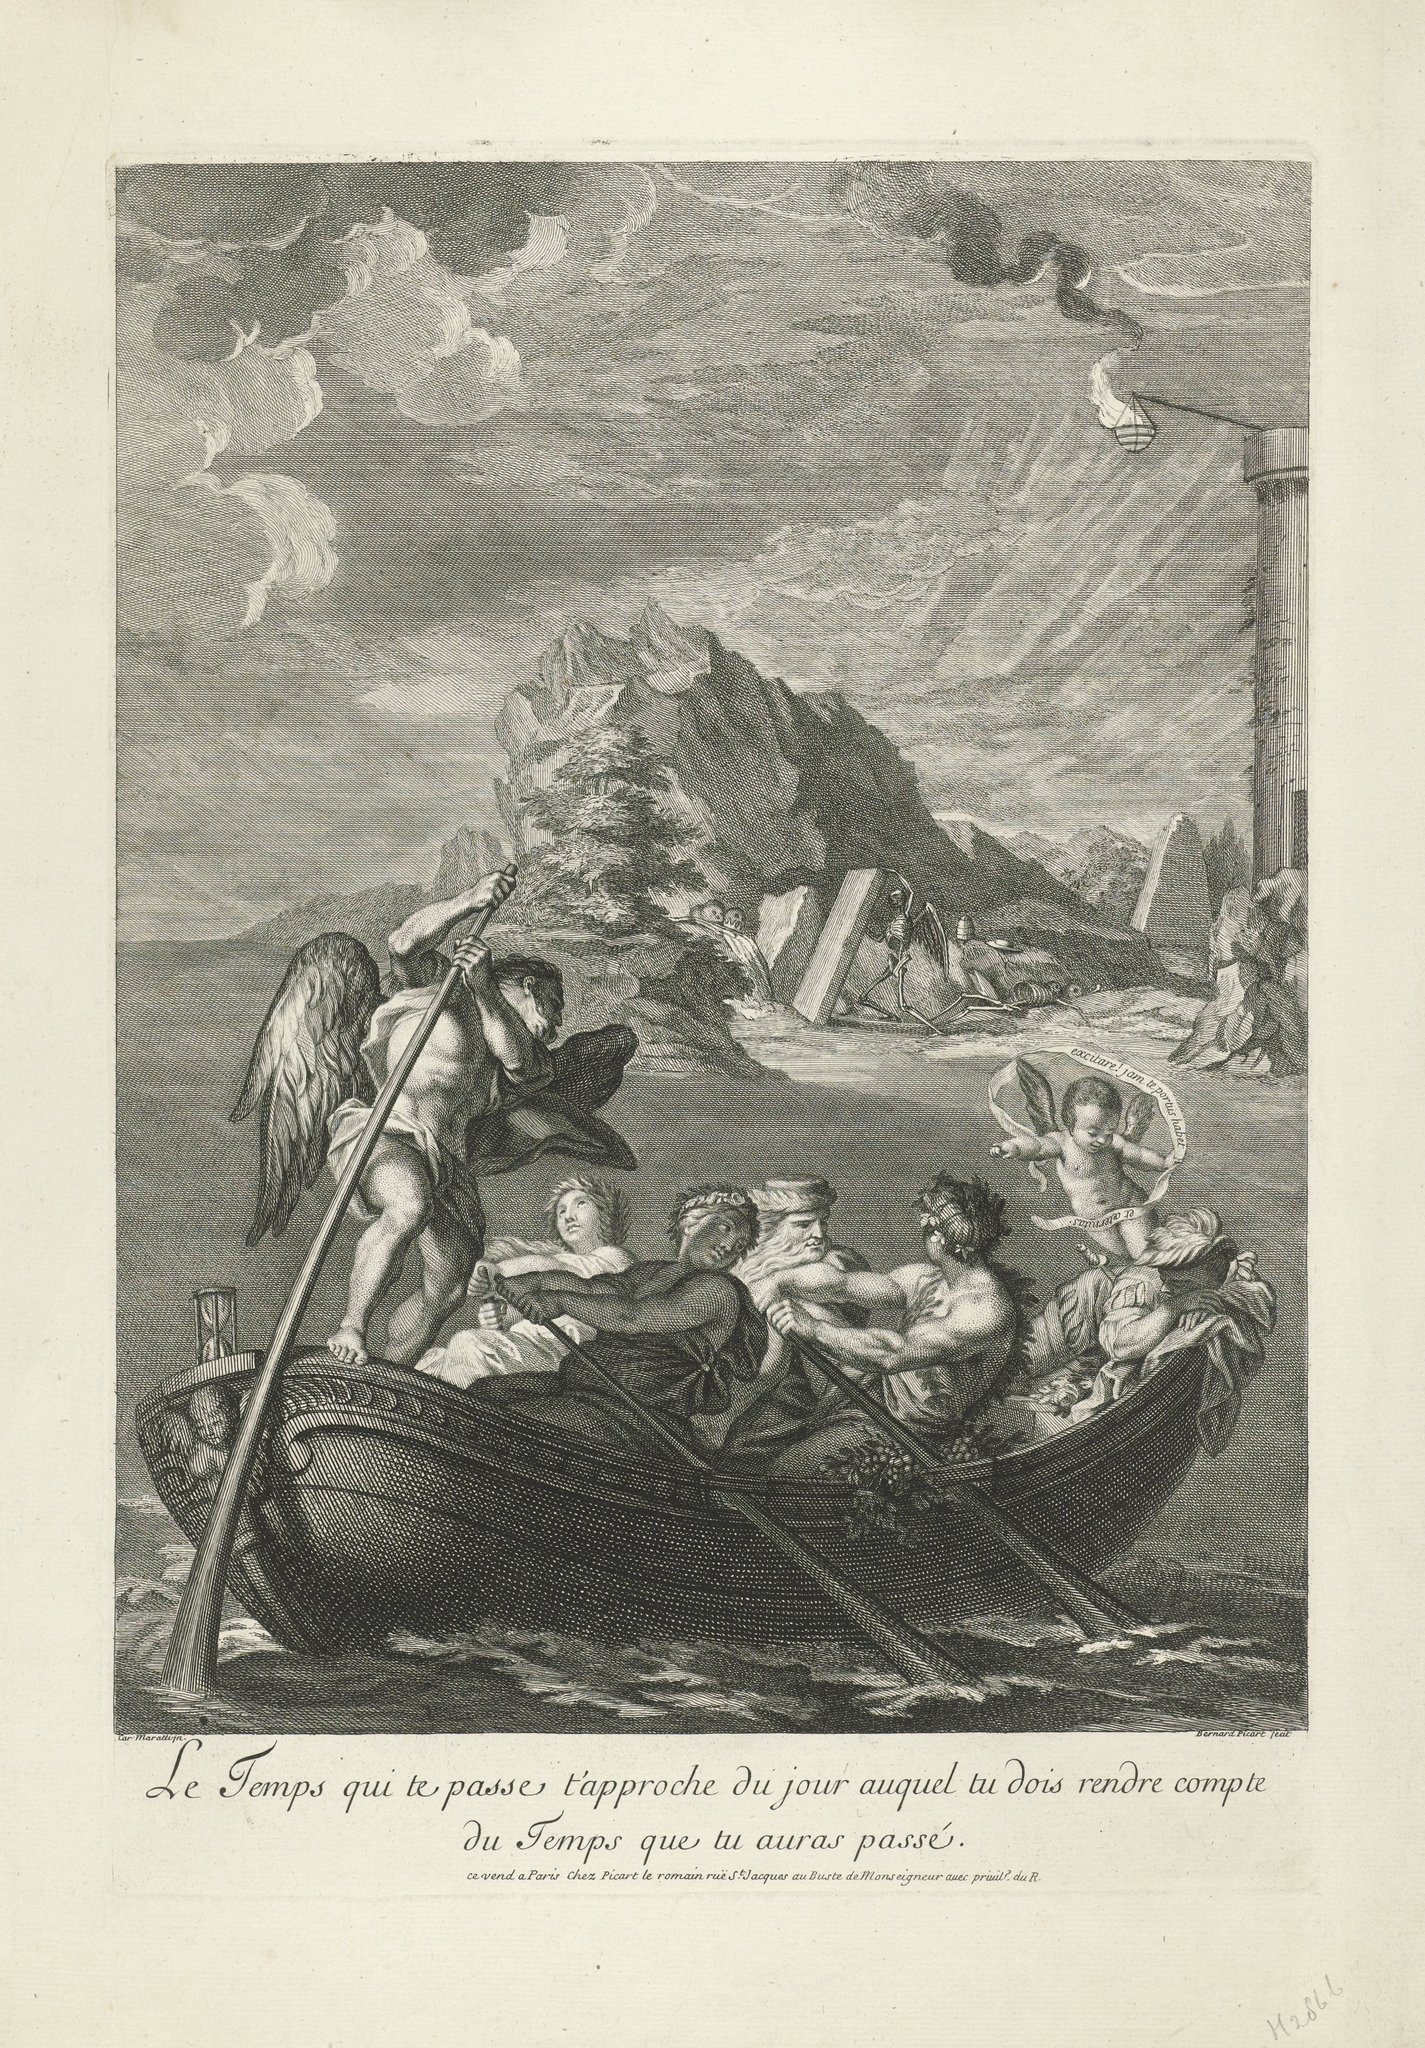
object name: print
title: Le Temps qui te passe t'approche du jour (...)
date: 1693-1696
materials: paper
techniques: engraving, etching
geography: paris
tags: human life; 'vita humana', 'vita inquieta', 'vita e l'animo' (ripa), seasons of the year (esp. personifications); 'stagione', 'le quattro stagione dell'anno' (ripa), ships (in general), the lifespan, father time, man with wings and scythe, death as skeleton - ff - death as female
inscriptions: collector's mark: Lugt 2228, collector's mark: Lugt 240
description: Vader Tijd en de personificaties van de vier seizoenen roeien een slapende man naar een eiland. Daar opent de Dood een graf. In de marge een tweeregelig onderschrift in het Frans.